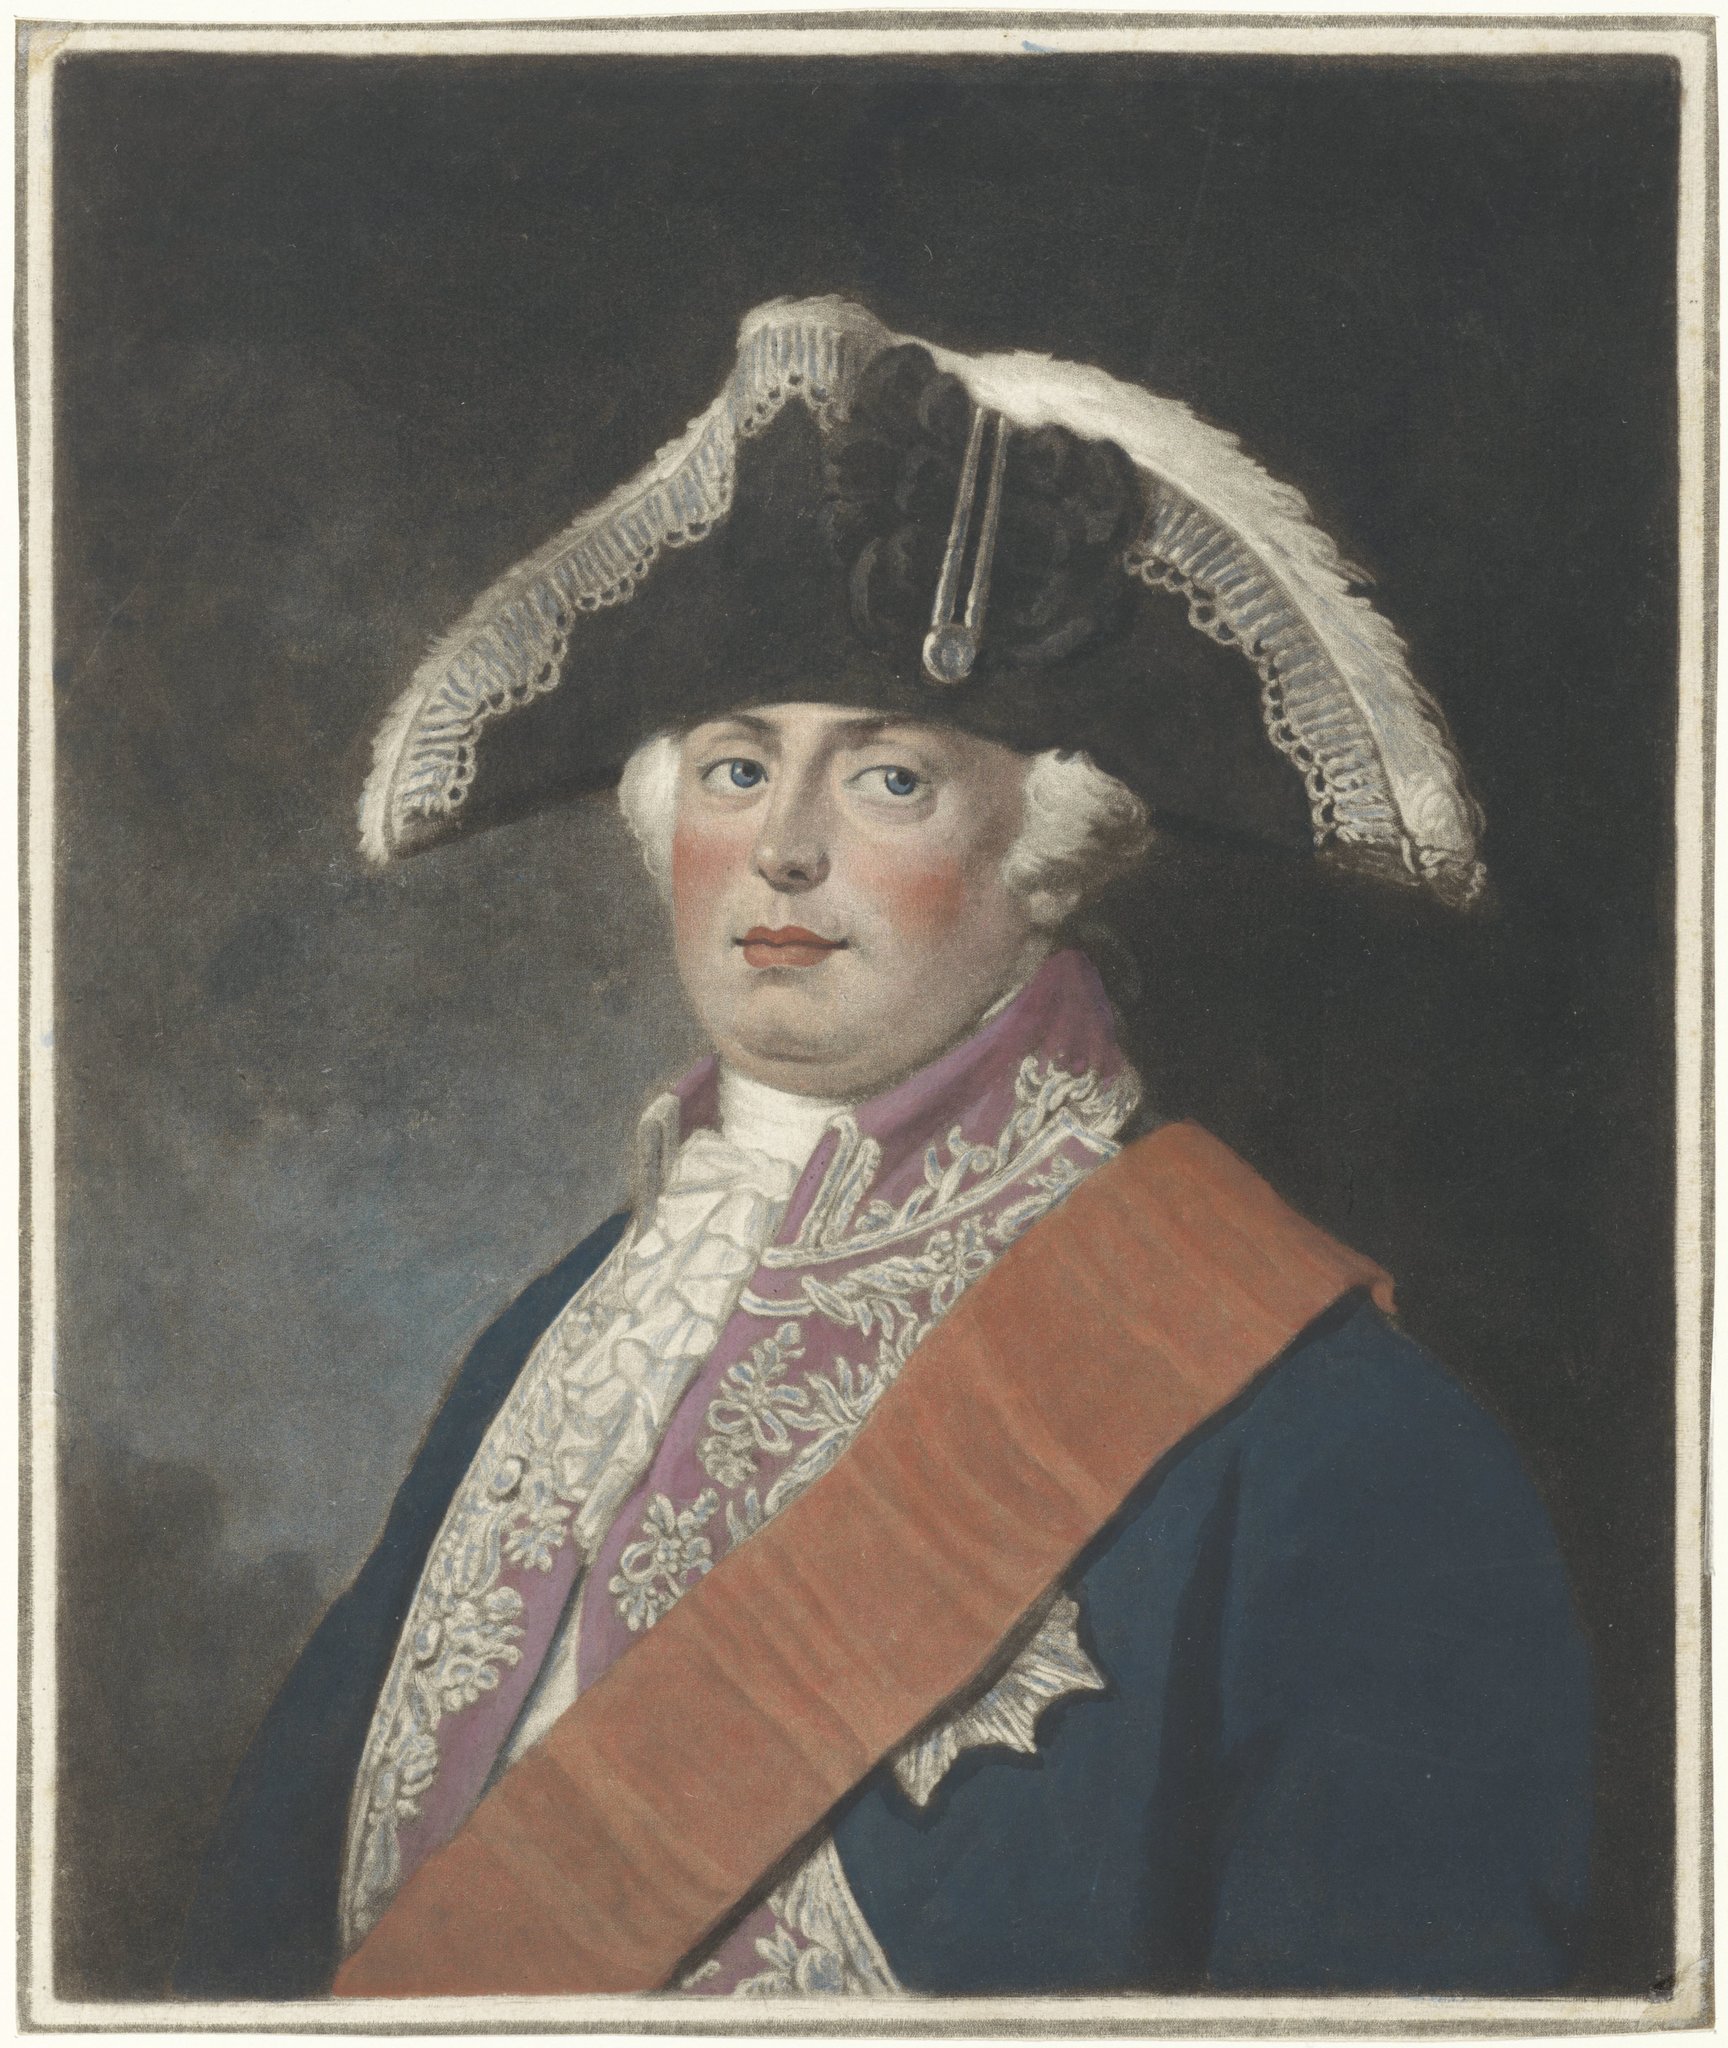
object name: print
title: Portret van Frederik Willem II, koning van Pruisen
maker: charles howard hodges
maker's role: draughtsman, painter, print maker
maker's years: 1764-1837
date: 1794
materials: paper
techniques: hand coloring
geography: netherlands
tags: berlin, frederik willem ii (koning van pruisen), head-gear: bicorne, bicorn (+ men's clothes)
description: Frederik Willem II, koning van Pruisen, met op het hoofd een steek.